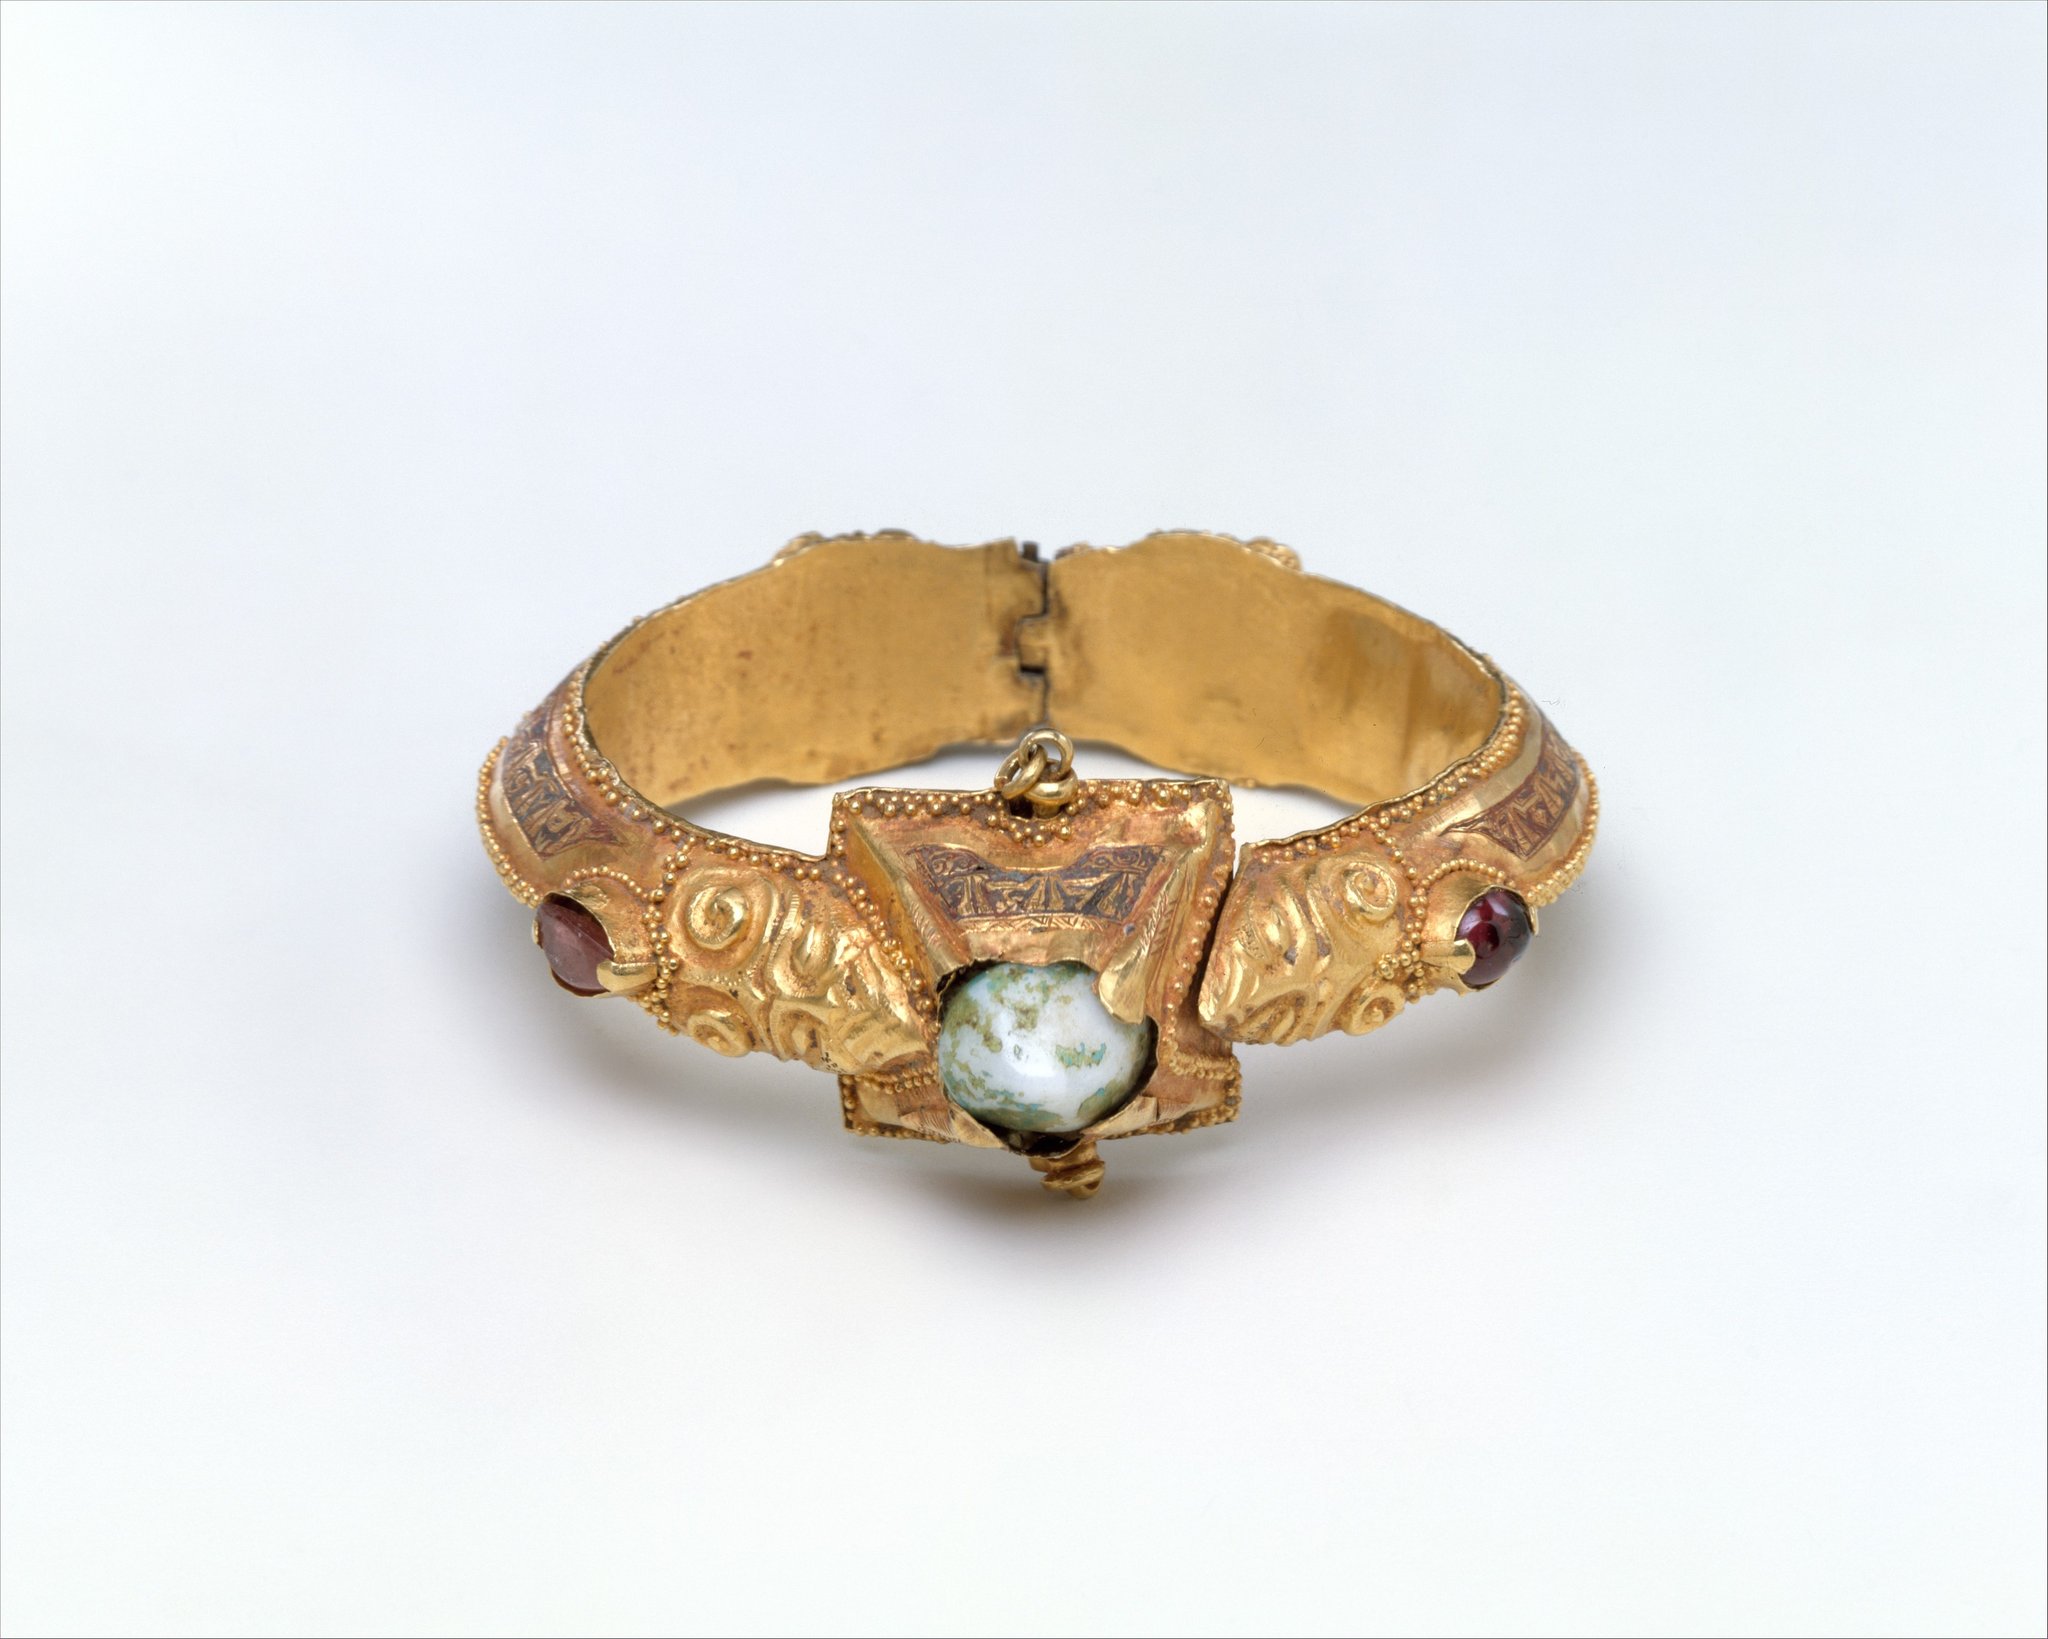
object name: bracelet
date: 1101-1200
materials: gemstone, gold, quartz, stone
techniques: glazing, highlighting, repoussé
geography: iran